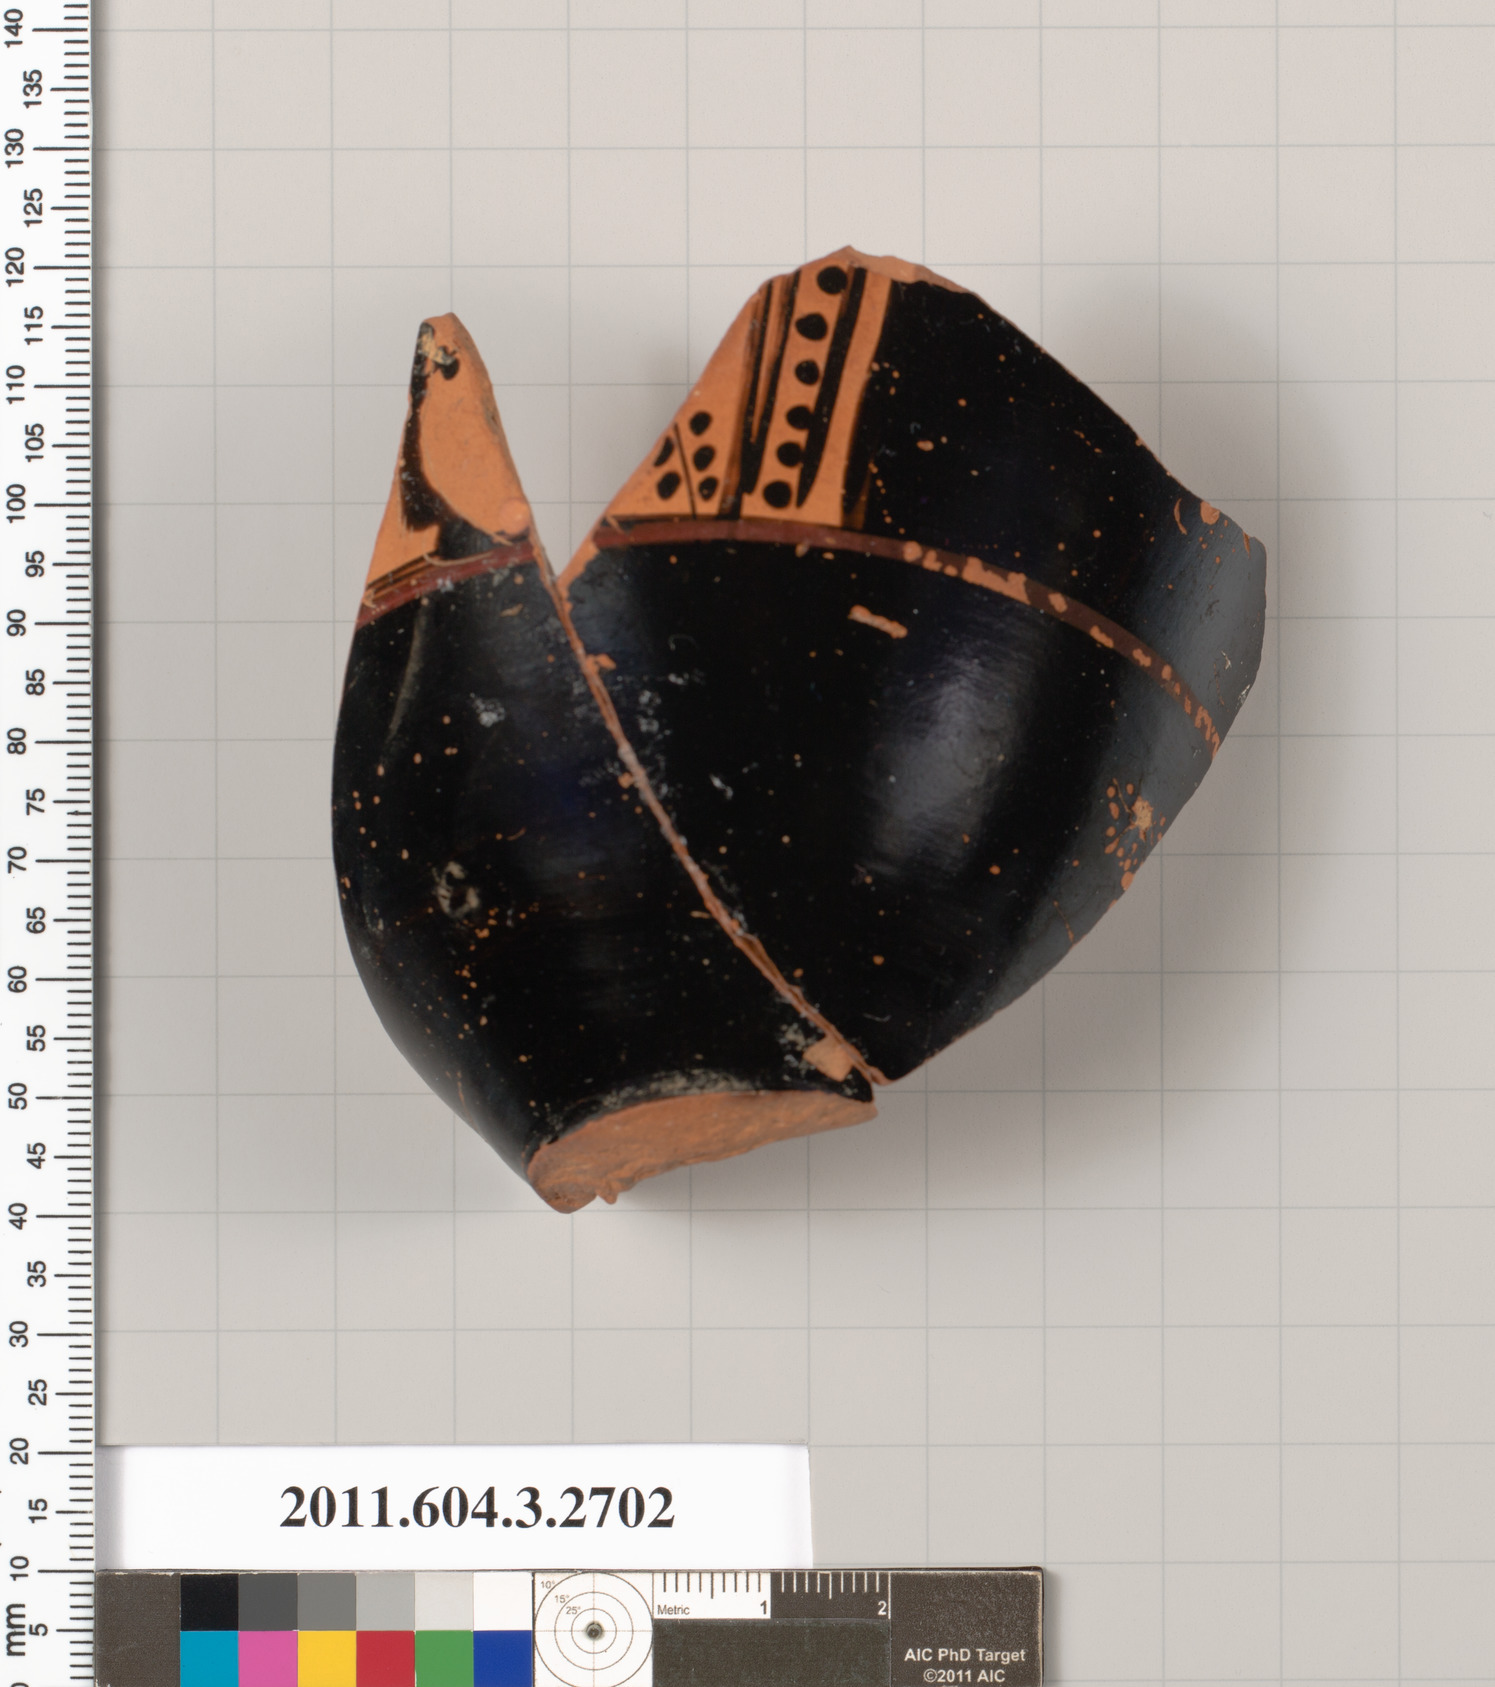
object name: oinochoe fragment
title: Terracotta fragment of an oinochoe (jug)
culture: greek, attic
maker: athena painter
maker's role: artist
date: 500-476 BCE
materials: terracotta